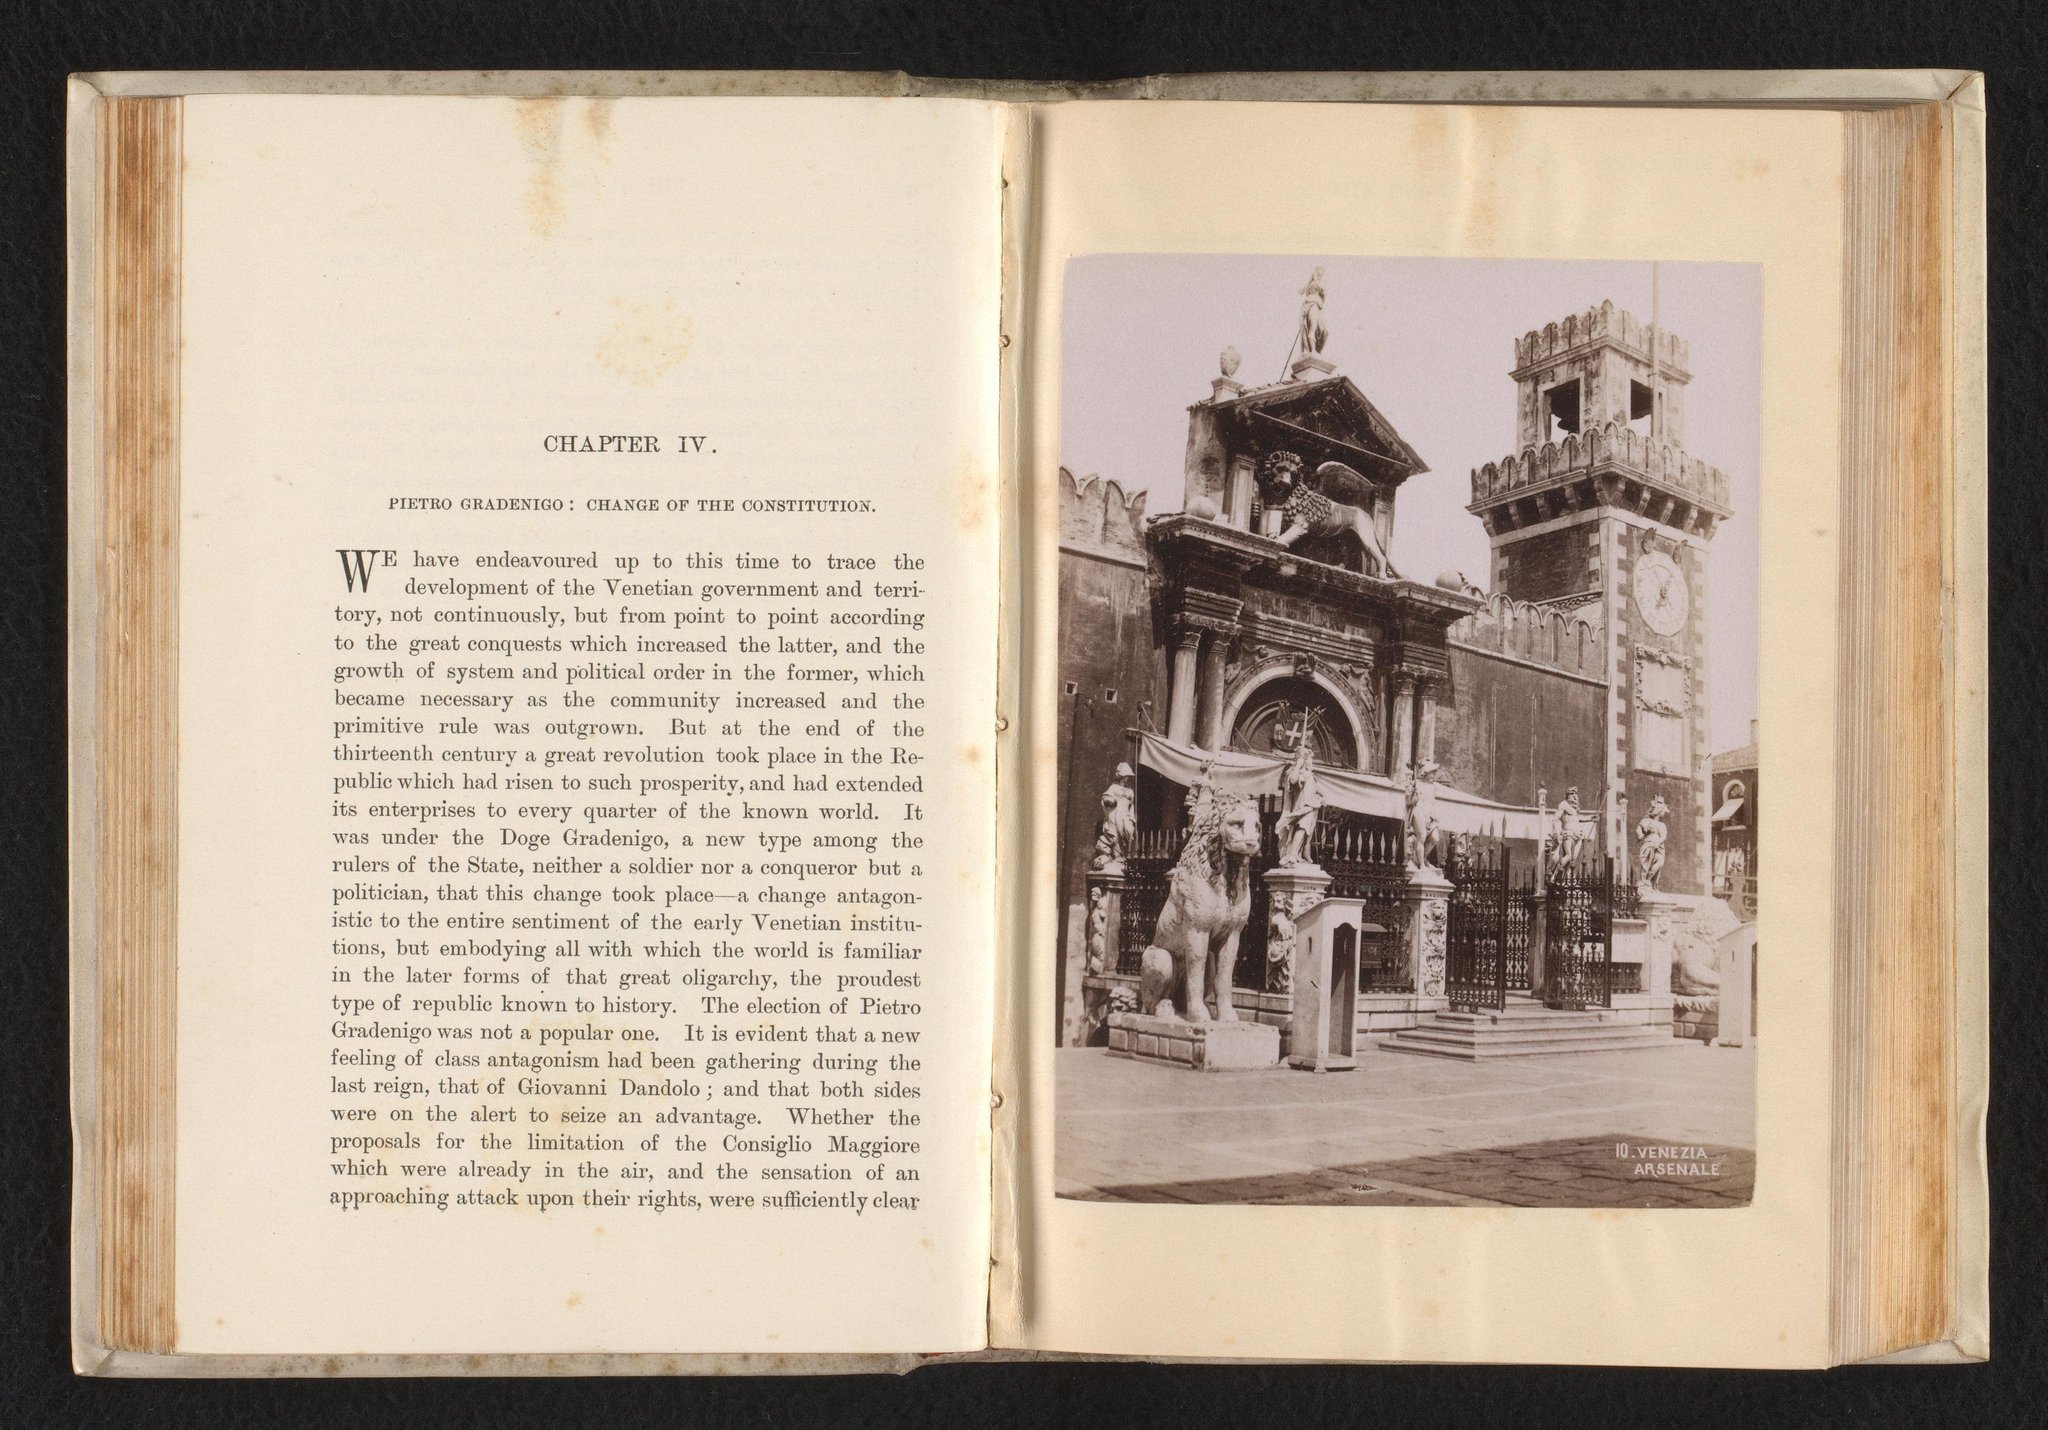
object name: photograph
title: Venezia, Arsenale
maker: Anonymous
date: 1888-1893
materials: paper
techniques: albumen print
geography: venice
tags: ammunition store, arsenal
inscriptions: number: ‘10.’